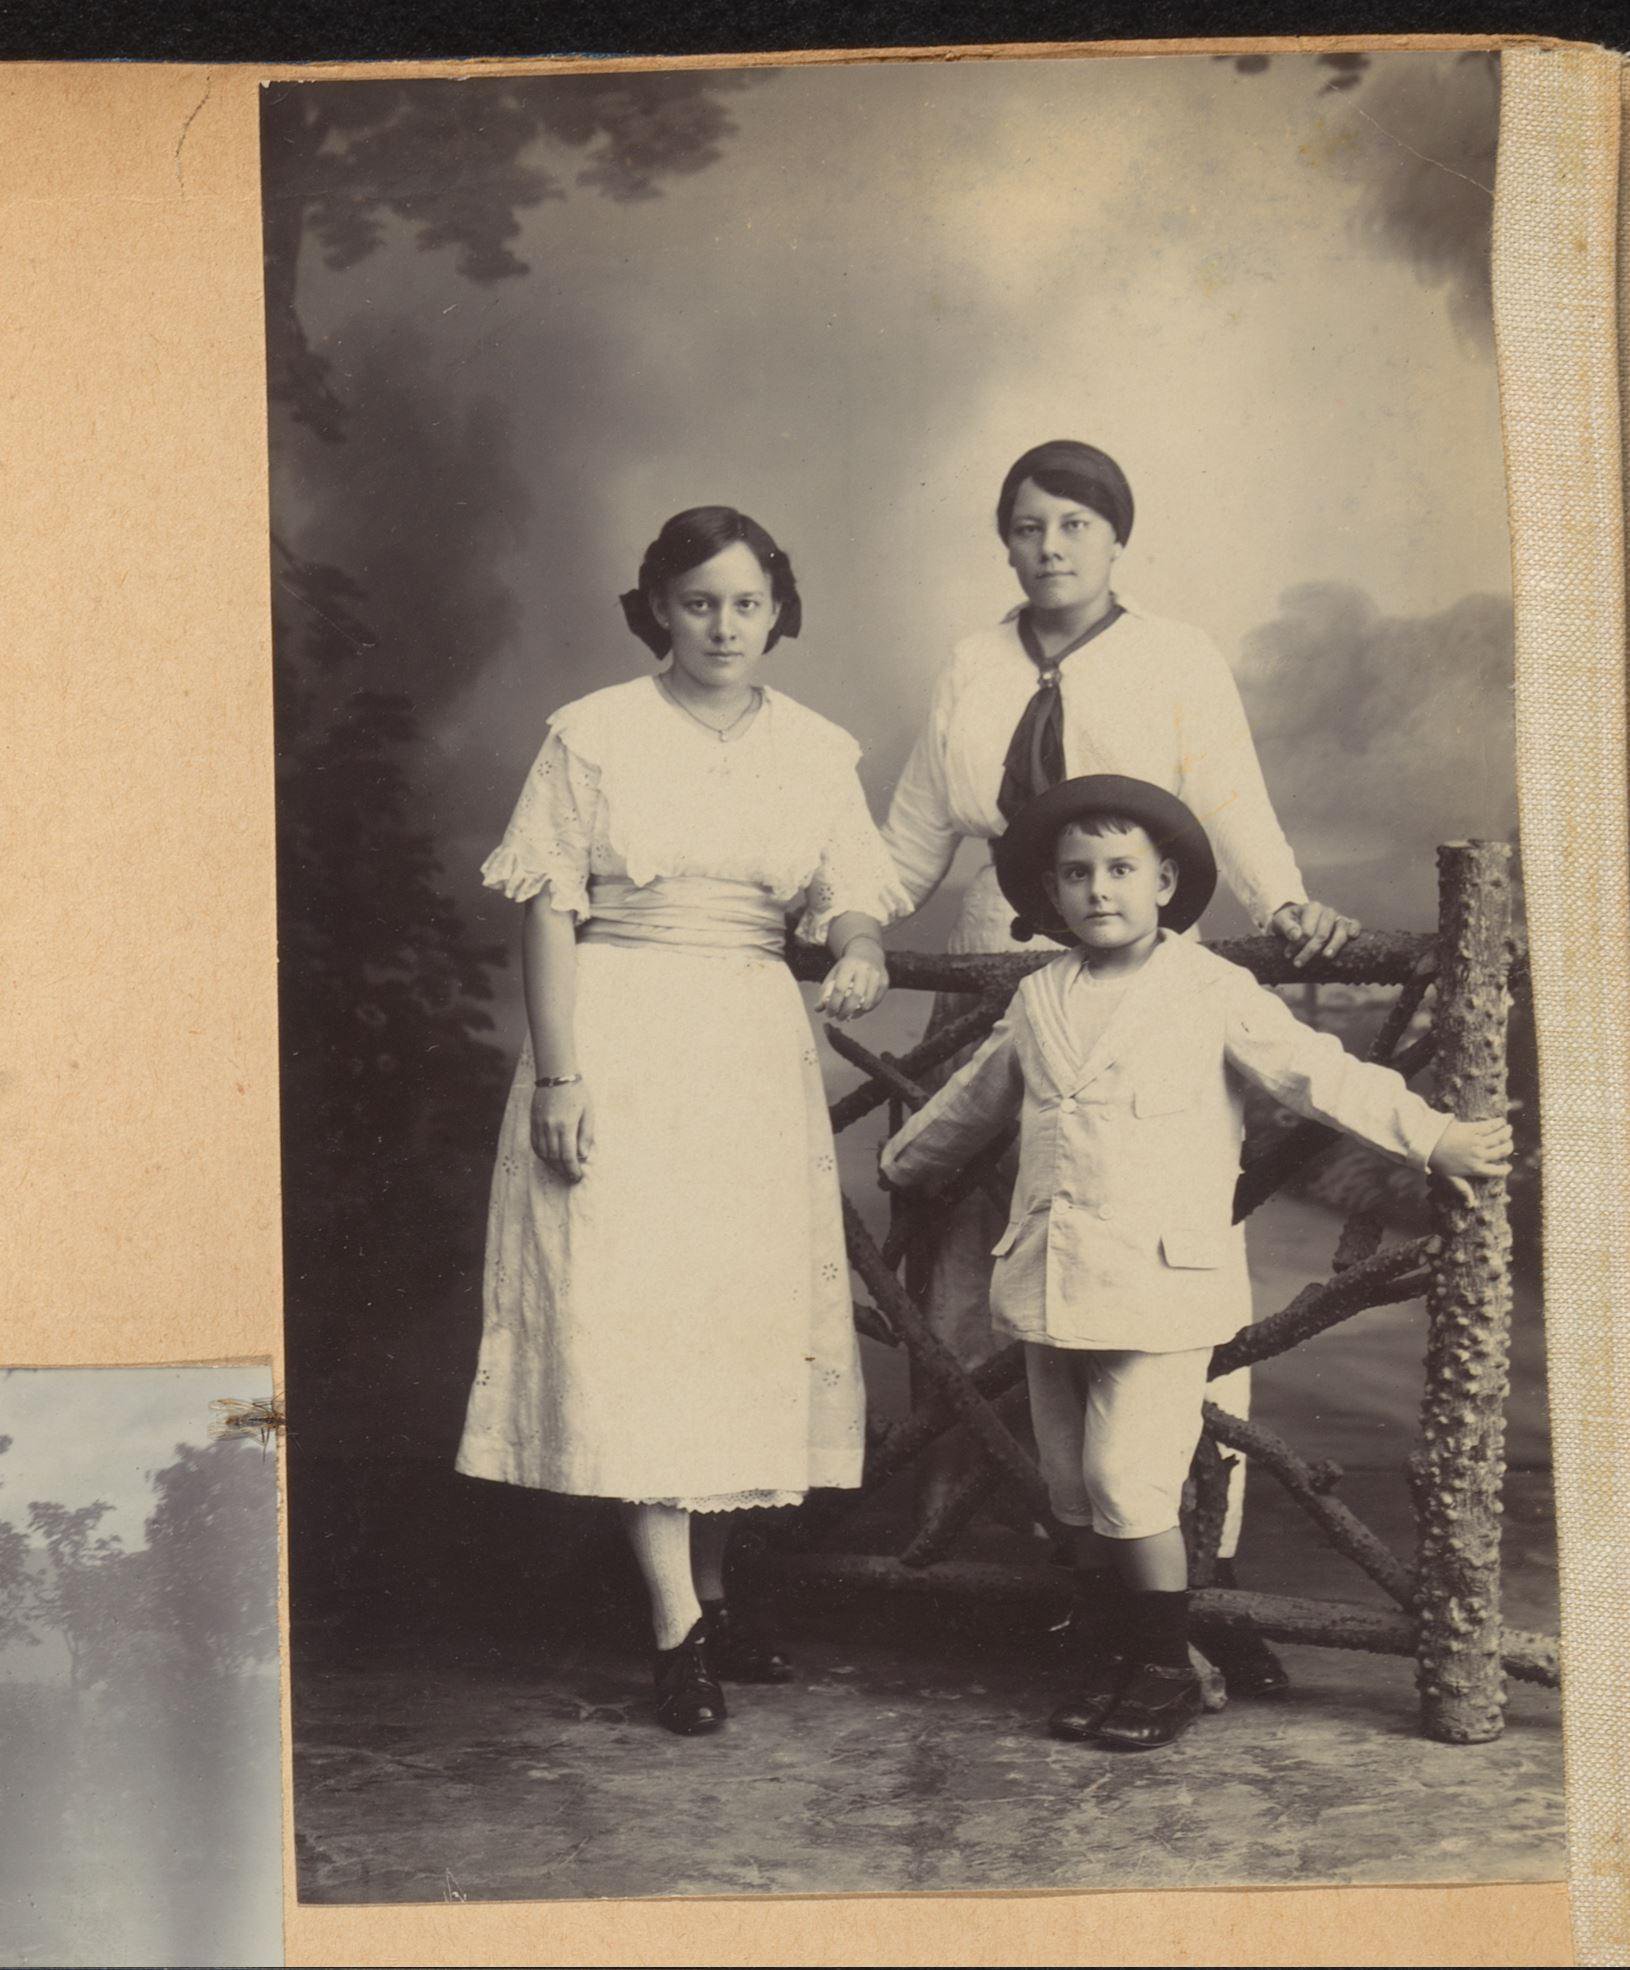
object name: photograph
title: Portret van twee jonge vrouwen en een kind, vermoedelijk in Nederlands-Indië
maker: Anonymous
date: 1917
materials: photographic support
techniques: gelatin silver print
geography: dutch east indies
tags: adolescent, young woman, maiden, studio requisites ~ photographer, child, dutch east indies, the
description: Onderdeel van Familiealbum met foto's van een familie in de voormalige kolonie Nederlands-Indië en van een suikerfabriek in Purworejo.